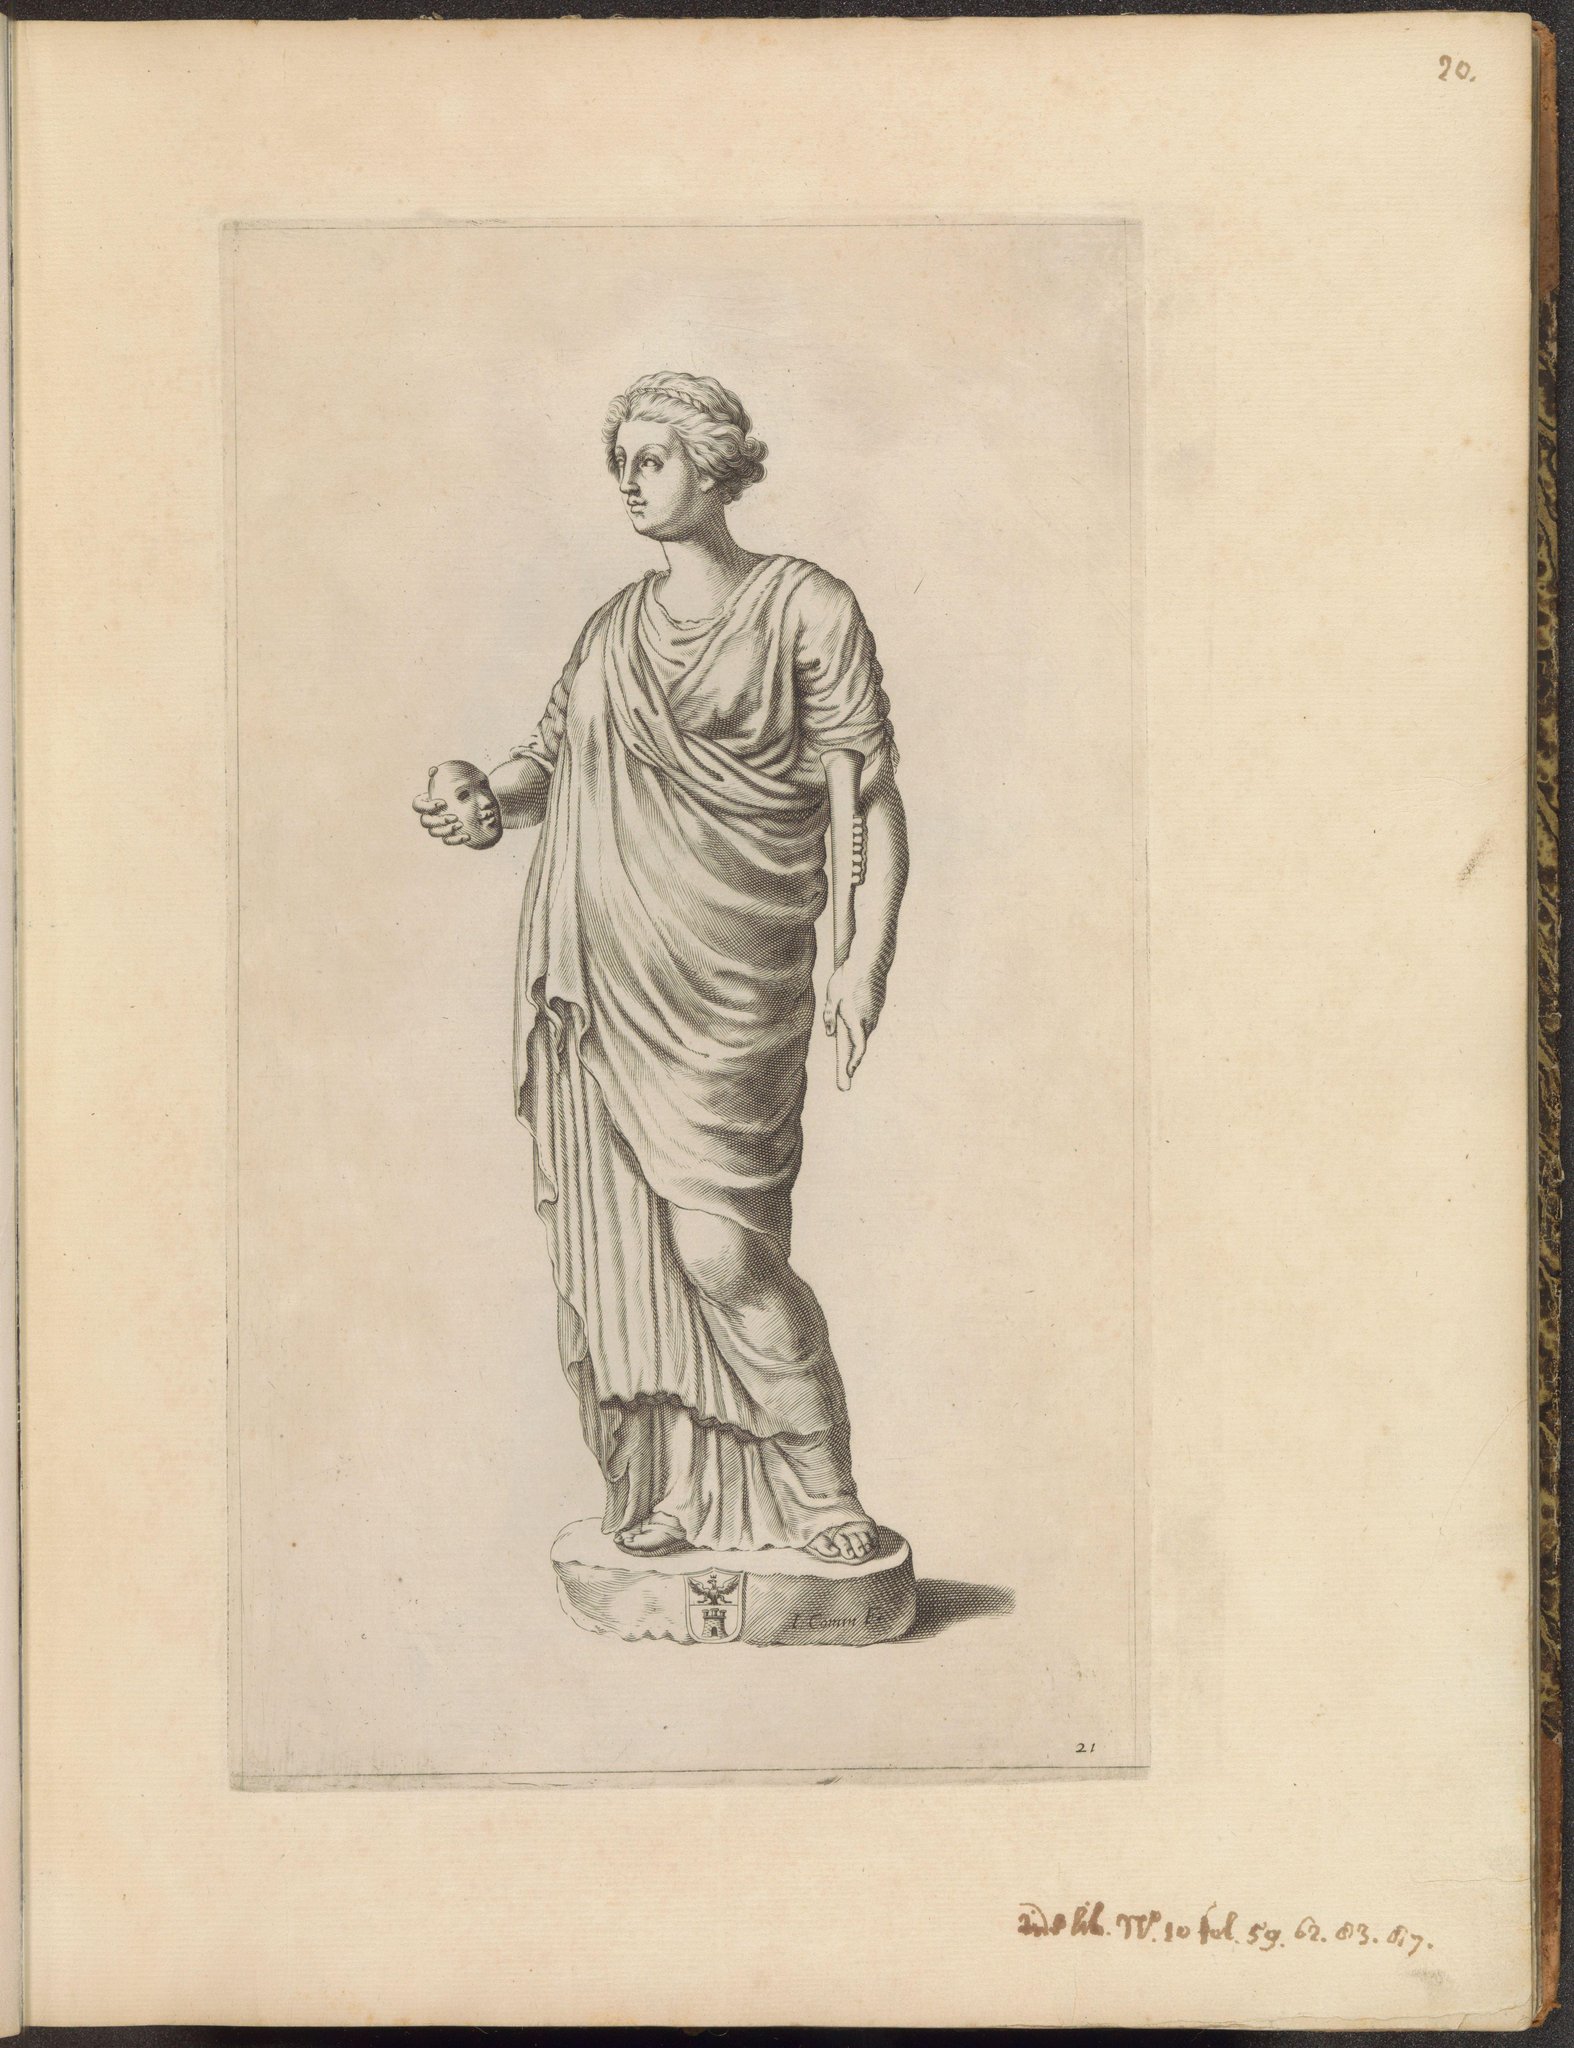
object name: album leaf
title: Galleria Giustiniana del Marchese Vincenzo Giustiniani I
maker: joan comin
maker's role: print maker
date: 1636-1647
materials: paper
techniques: engraving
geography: rome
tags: piece of sculpture, reproduction of a piece of sculpture, single muses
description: Een standbeeld van een muze met masker en blaasinstrument in haar handen. Wellicht Thalia. Op de basis het wapenschild van Vincenzo Giustiniani. Prent maakt deel uit van een album met een serie prenten naar de sculpturen in de verzameling in de Galleria Giustiniani te Rome.